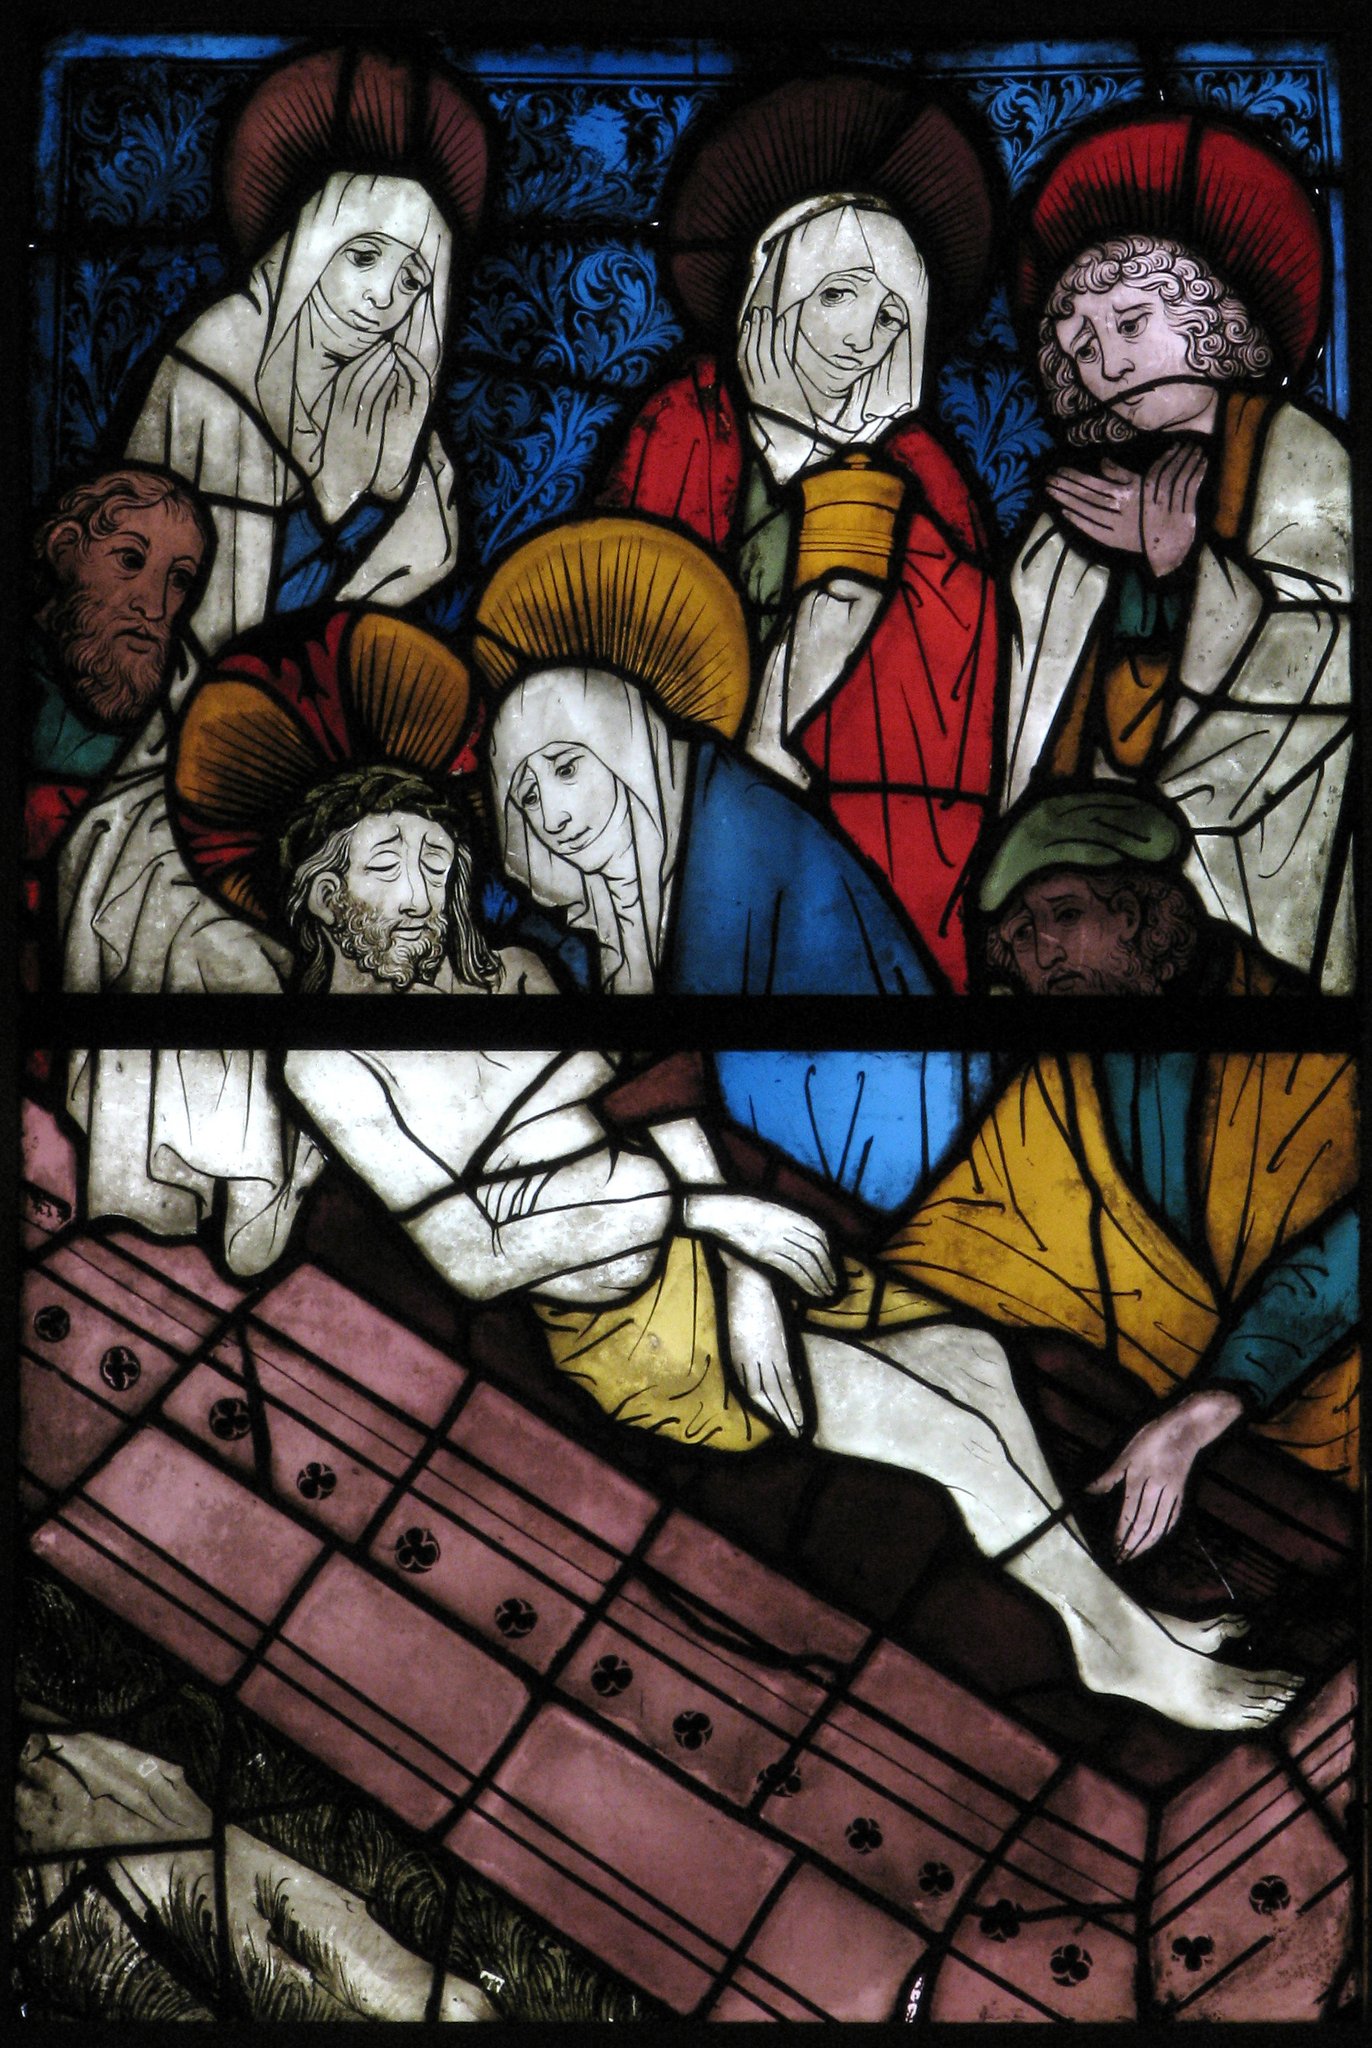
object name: panel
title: Stained Glass Panel with the Entombment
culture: german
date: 1401-1500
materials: glass, metal, paint, pigment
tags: men,women,entombment